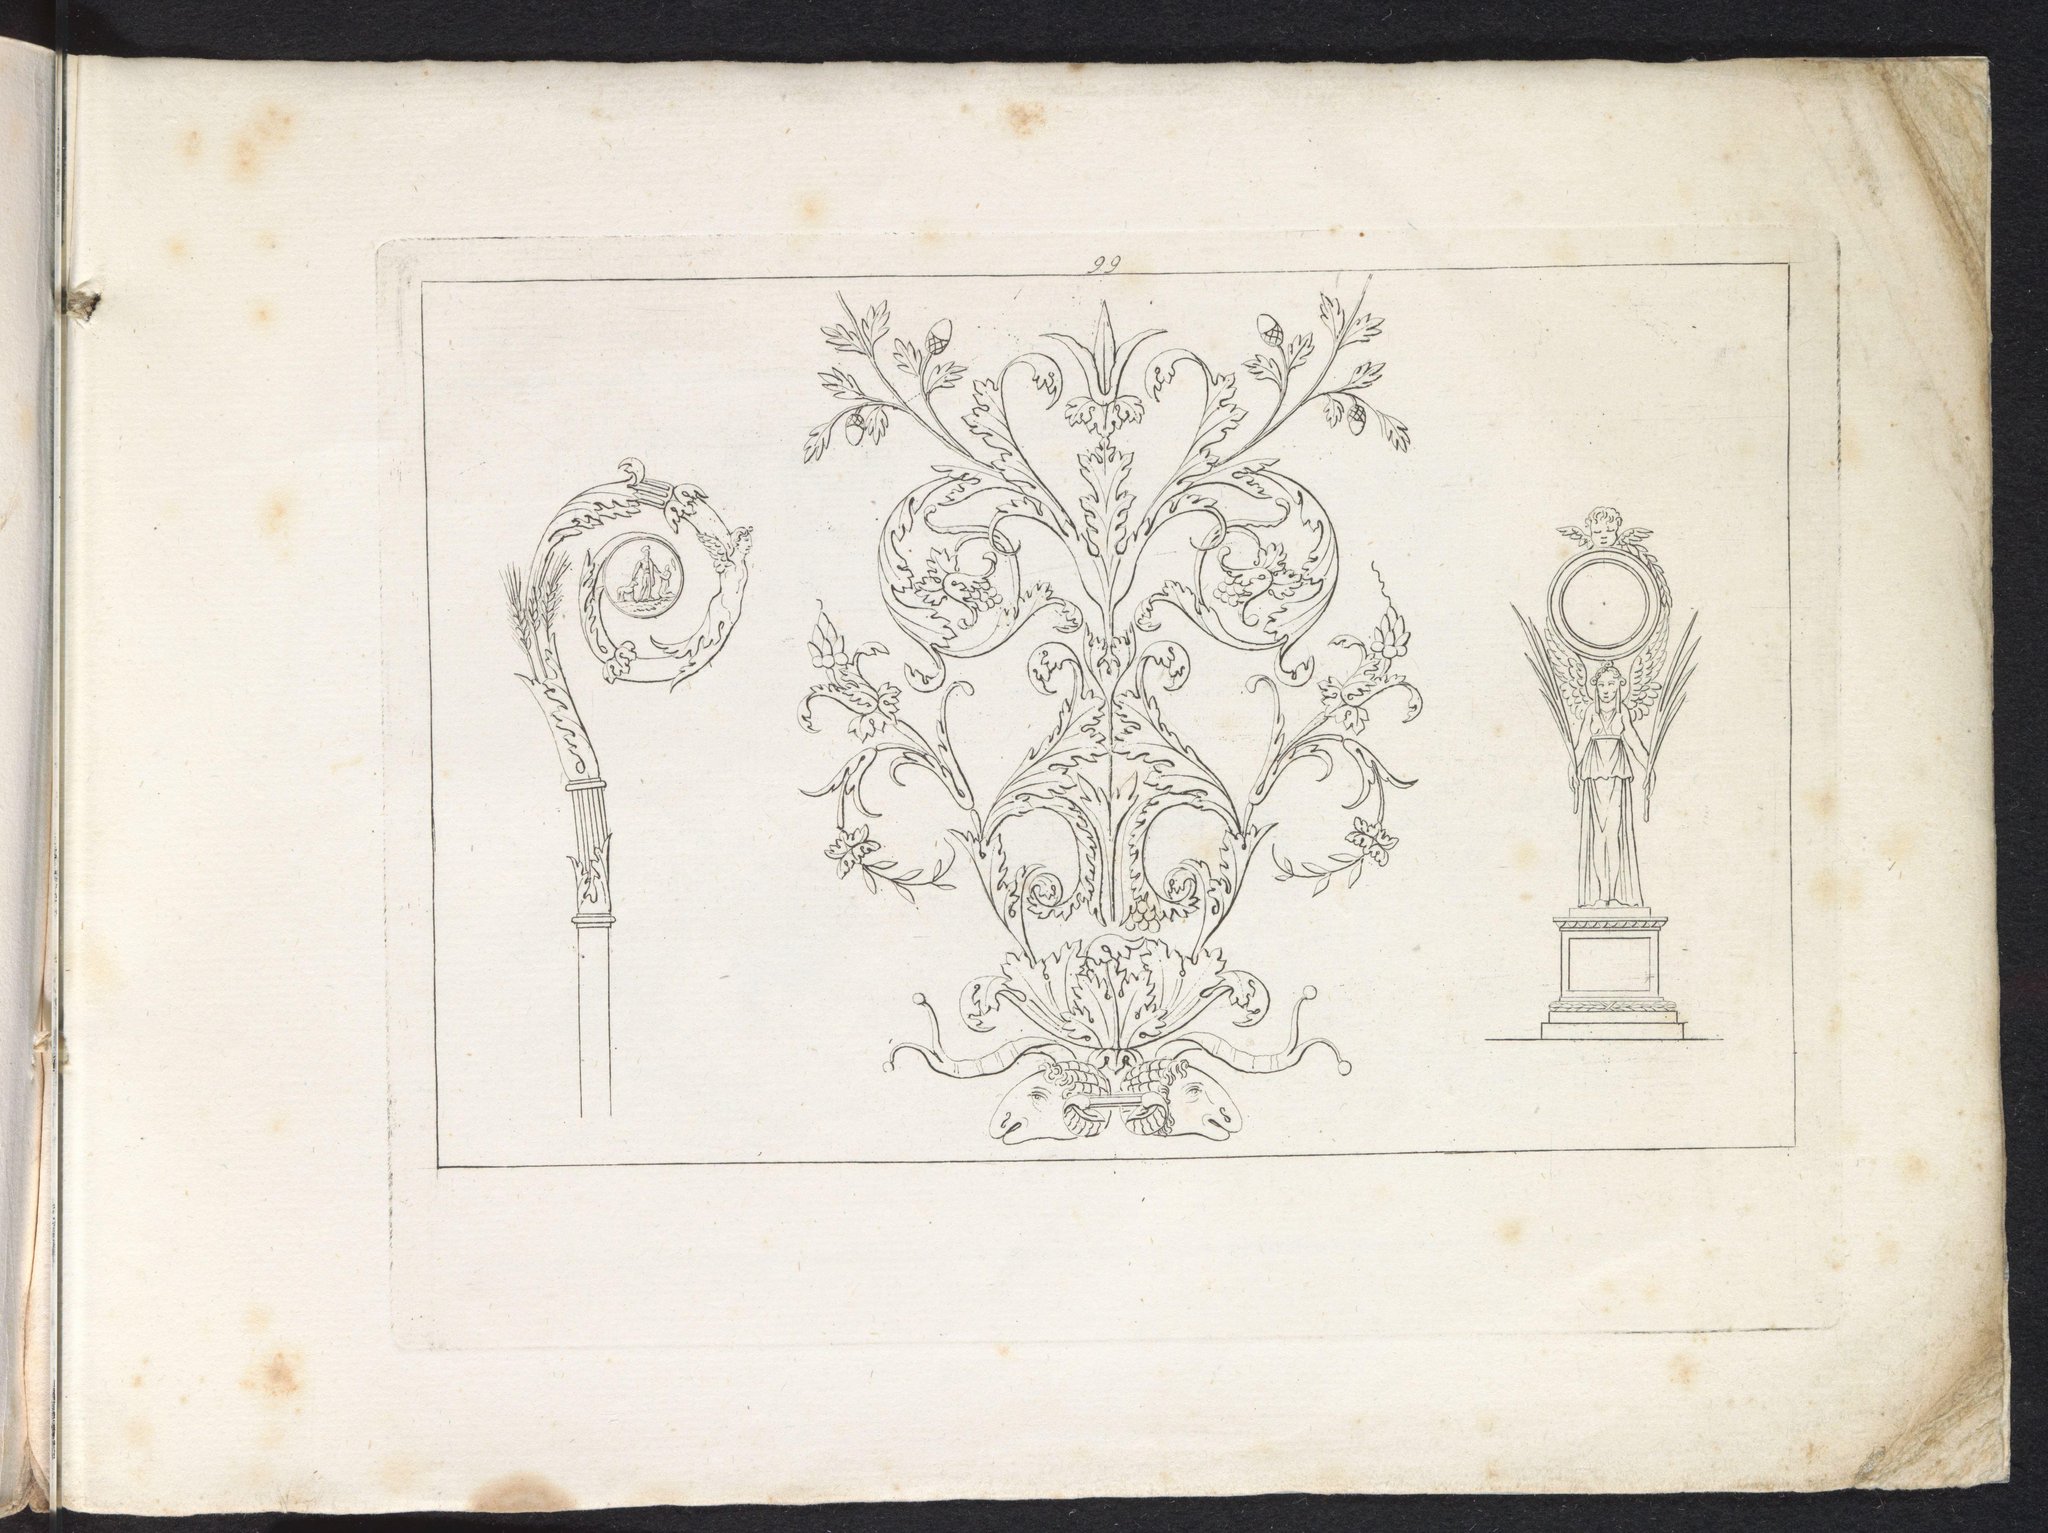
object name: print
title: Ontwerpen voor religieuze en profane voorwerpen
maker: pietro ruga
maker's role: print maker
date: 1817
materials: paper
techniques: etching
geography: italy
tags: ornaments ~ art, ornament ~ arabesque, ostensorium, monstrance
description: Prent maakt deel uit van een reeks van 100 prenten (+ titelprent) met ontwerpen voor religieuze en profane voorwerpen.